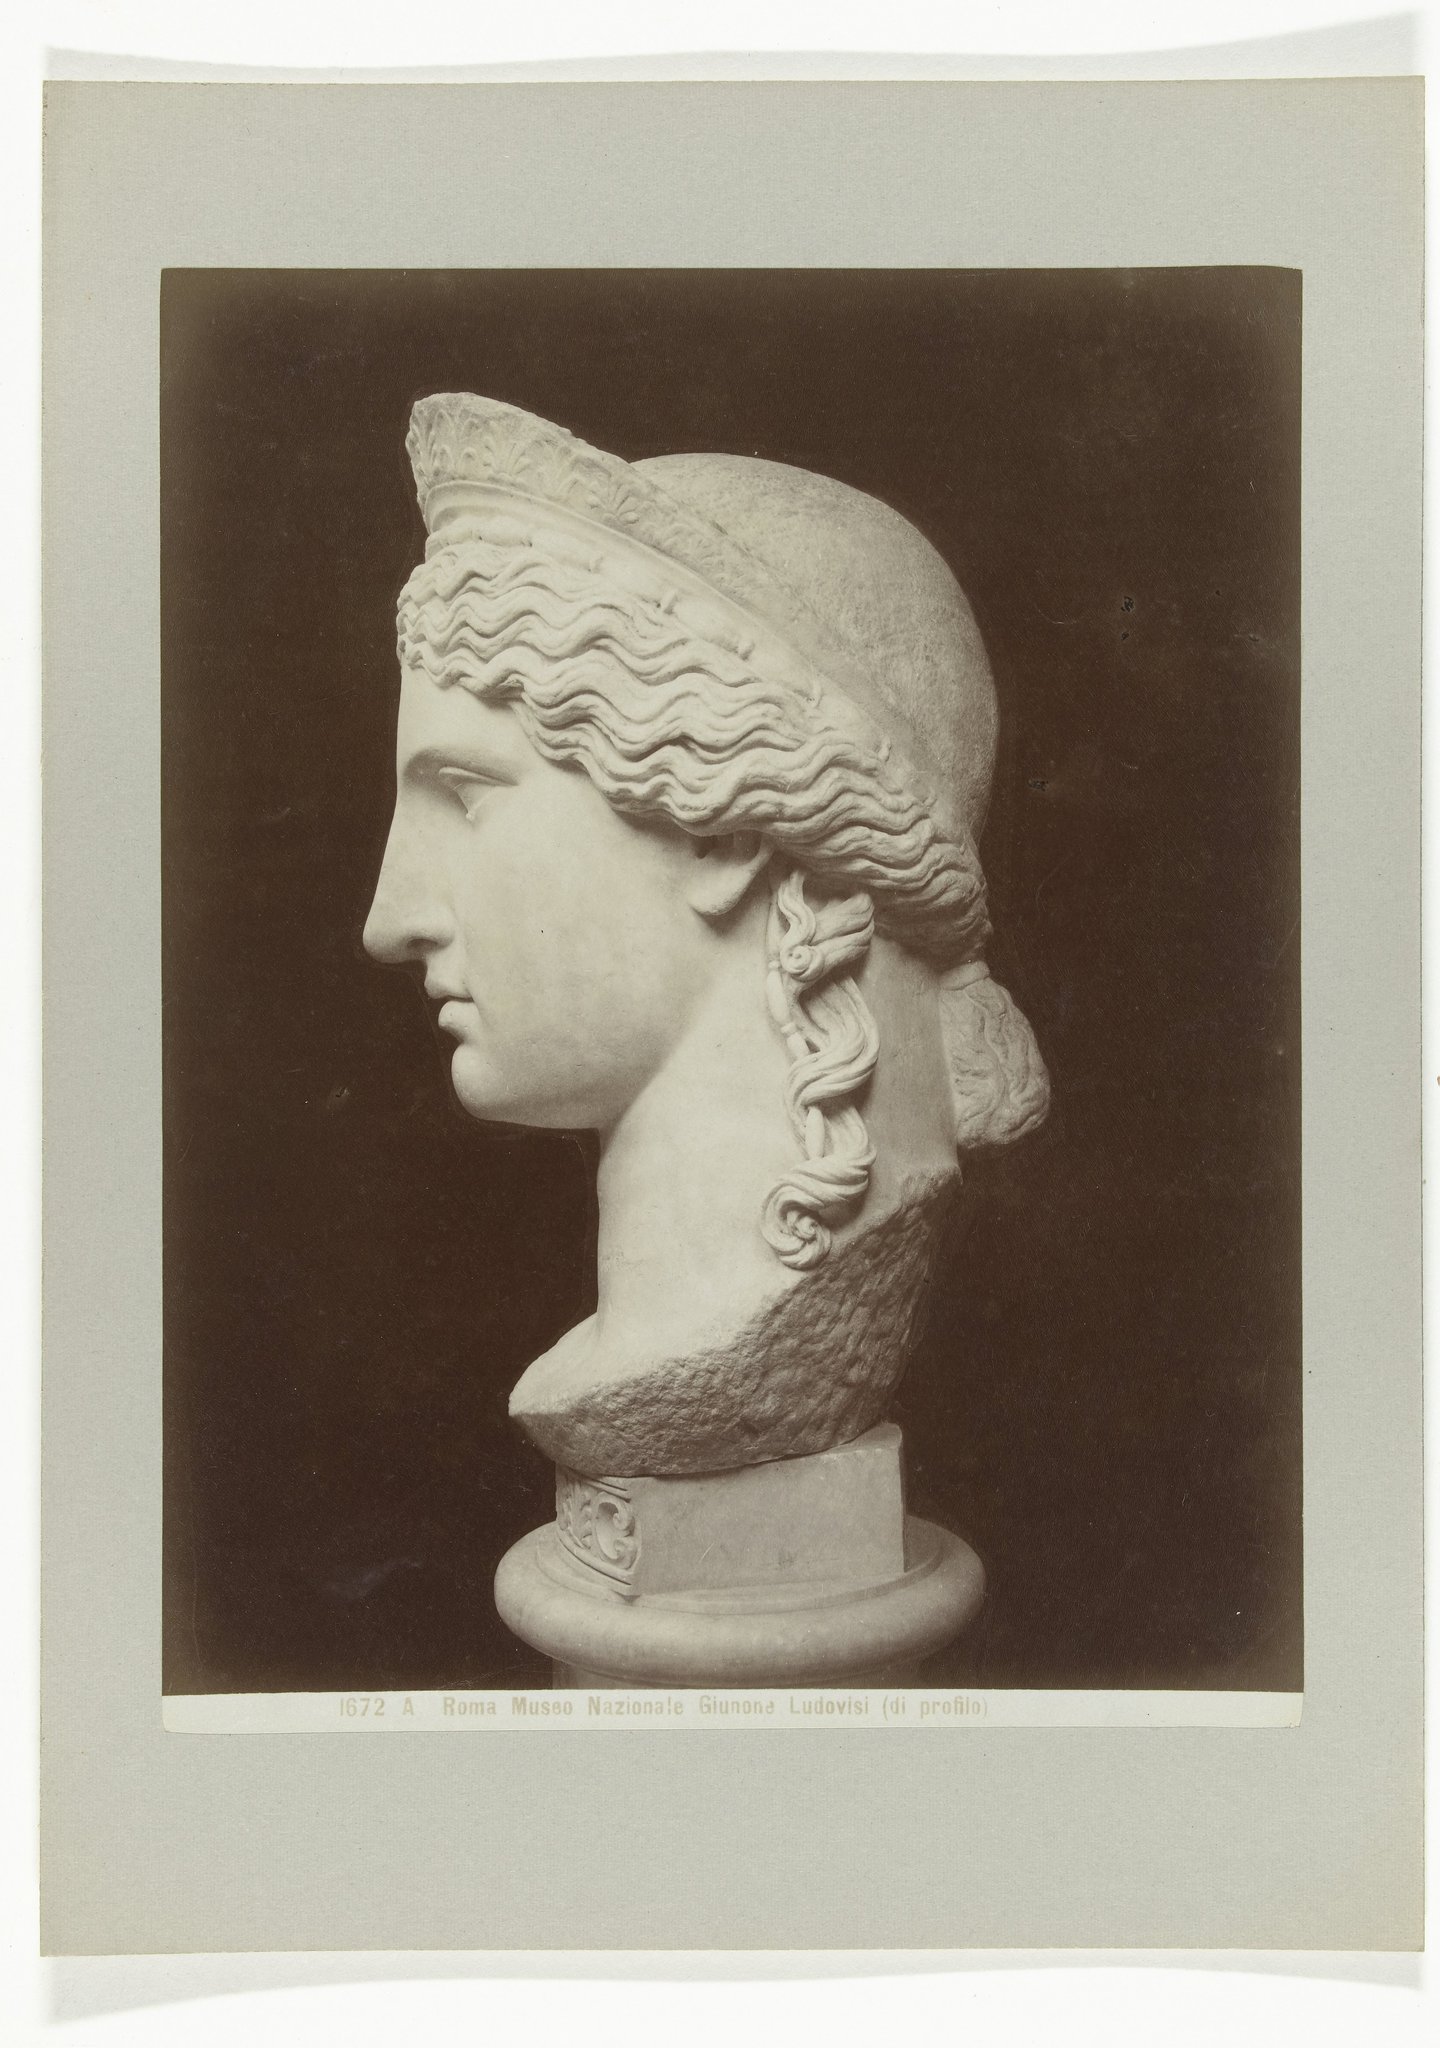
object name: photograph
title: Buste van Giunone Ludovisi in profiel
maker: Anonymous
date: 1880-1904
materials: cardboard, paper, photographic support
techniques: albumen print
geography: rome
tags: rome